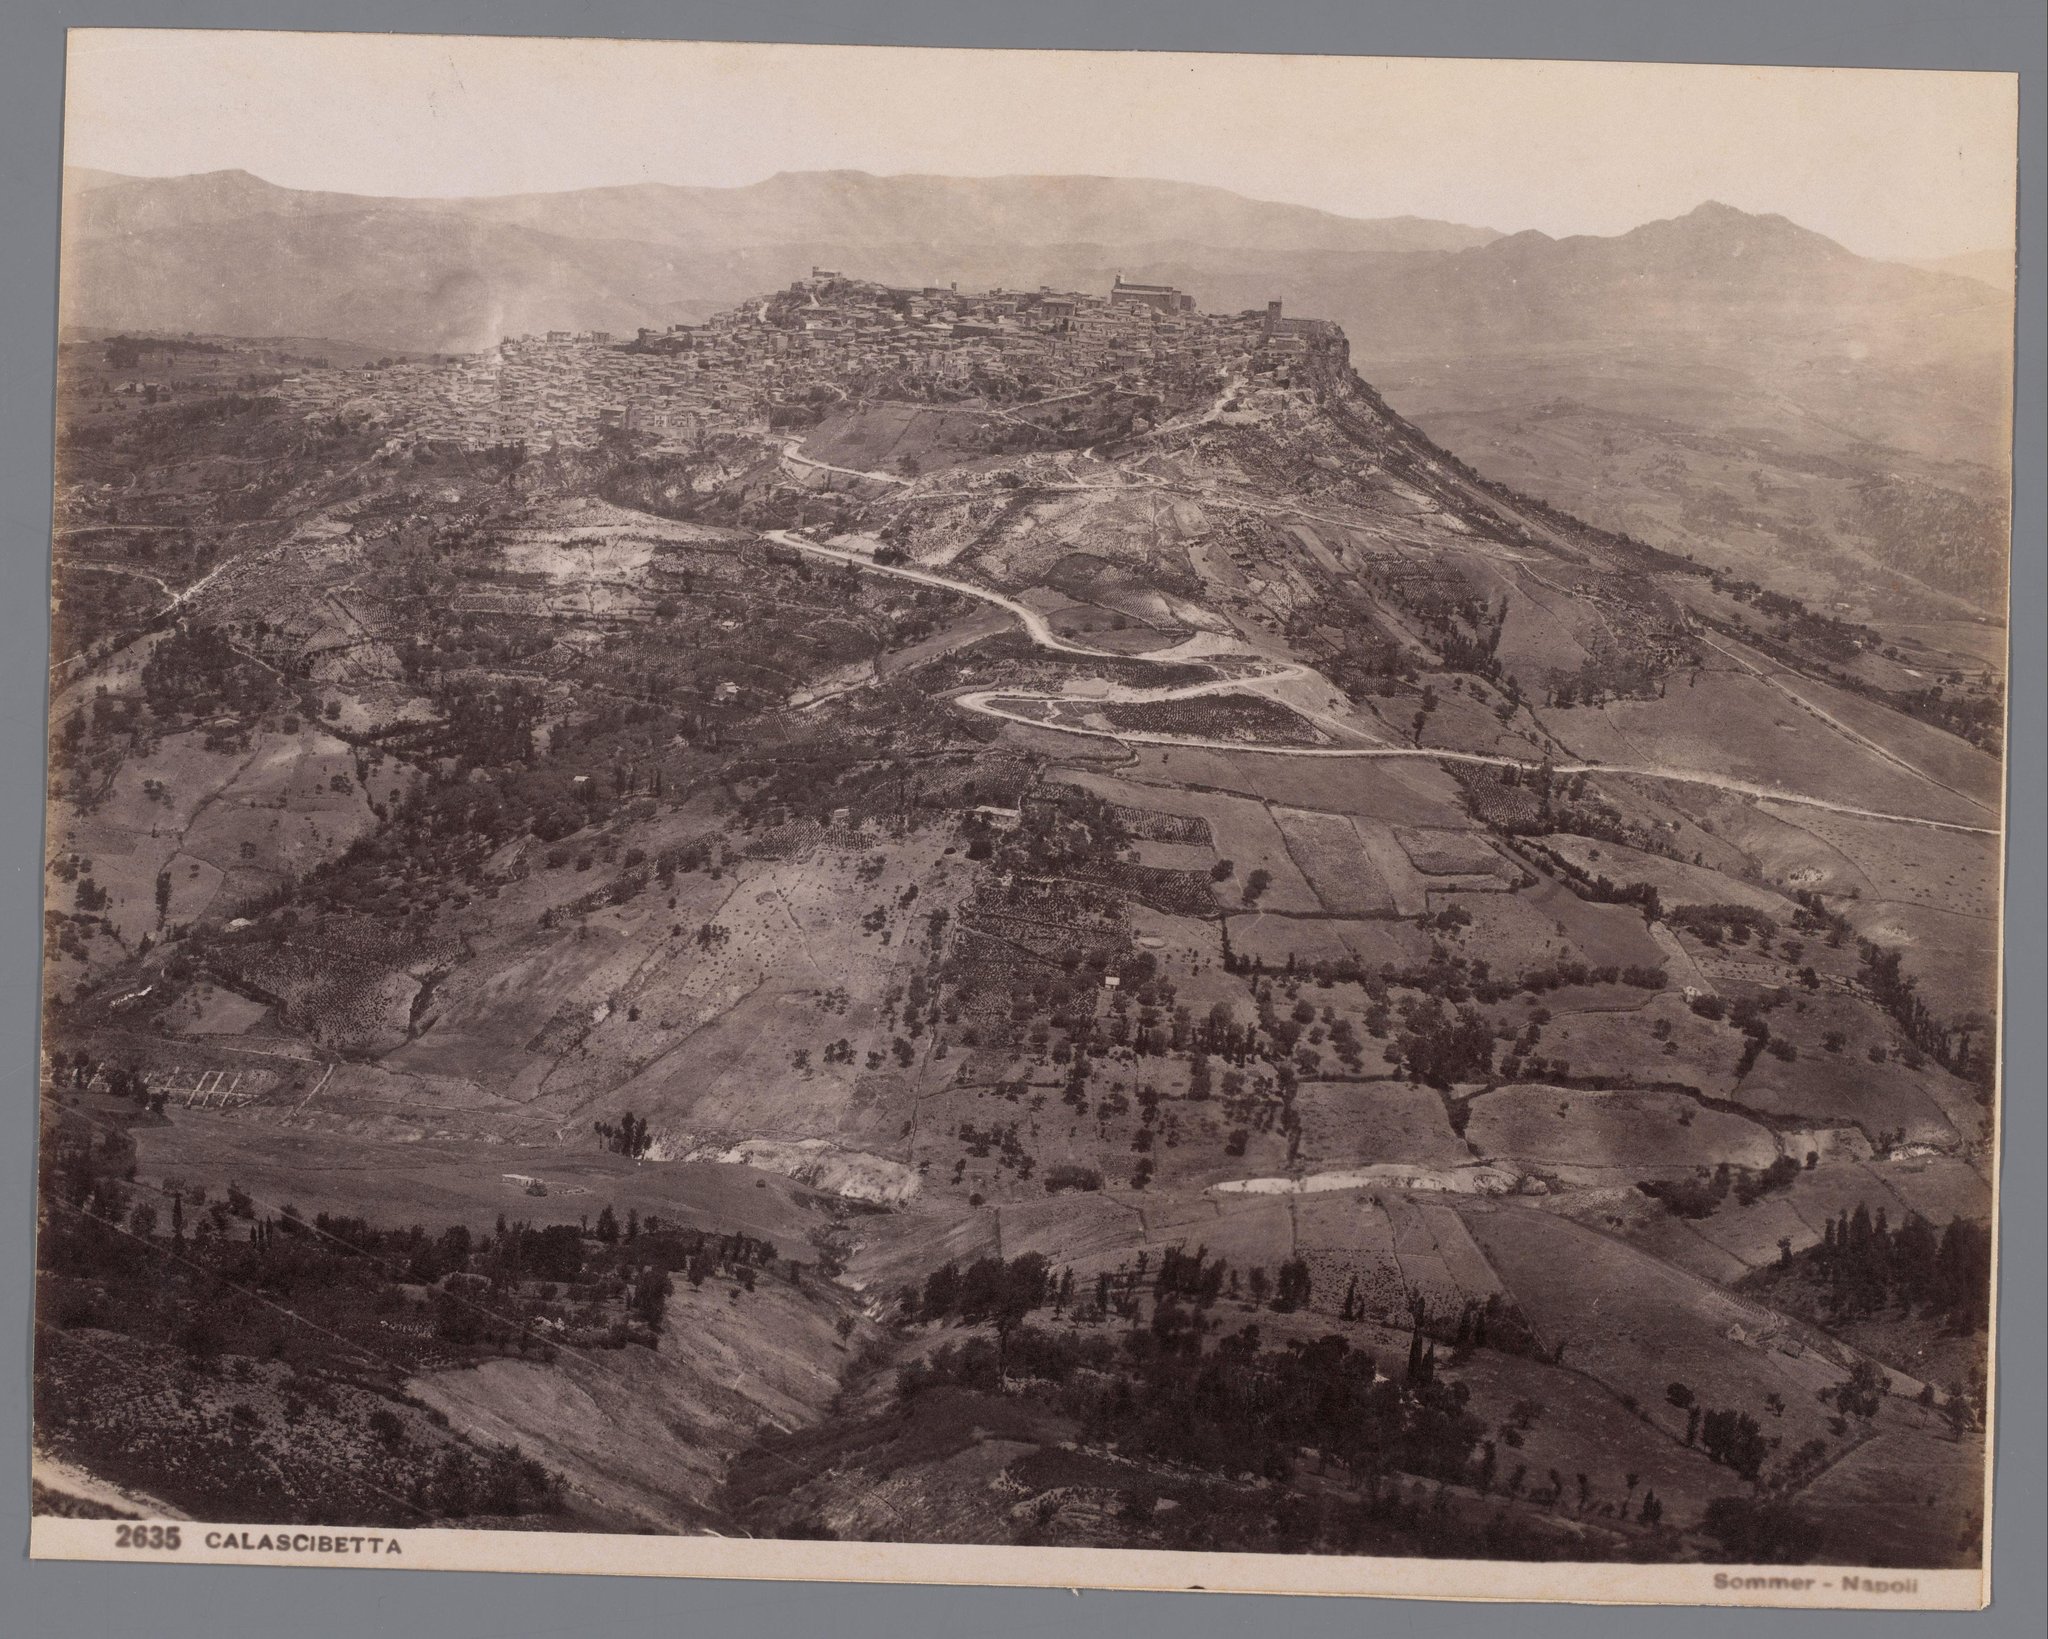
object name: photograph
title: Gezicht op Calascibetta op Sicilië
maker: giorgio sommer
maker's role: fotograaf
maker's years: 1834-1914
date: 1857-1900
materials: cardboard, paper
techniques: albumen print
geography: calascibetta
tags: dale, valley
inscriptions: number: ‘2635’